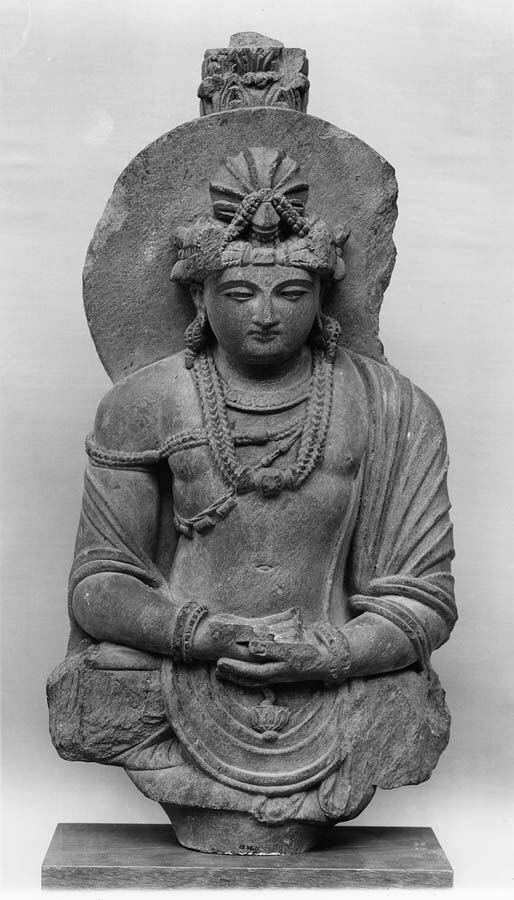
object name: statue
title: Seated Bodhisattva, Possibly Padmapani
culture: gandhara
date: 201-500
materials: stone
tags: gandhara,buddhism,bodhisattvas